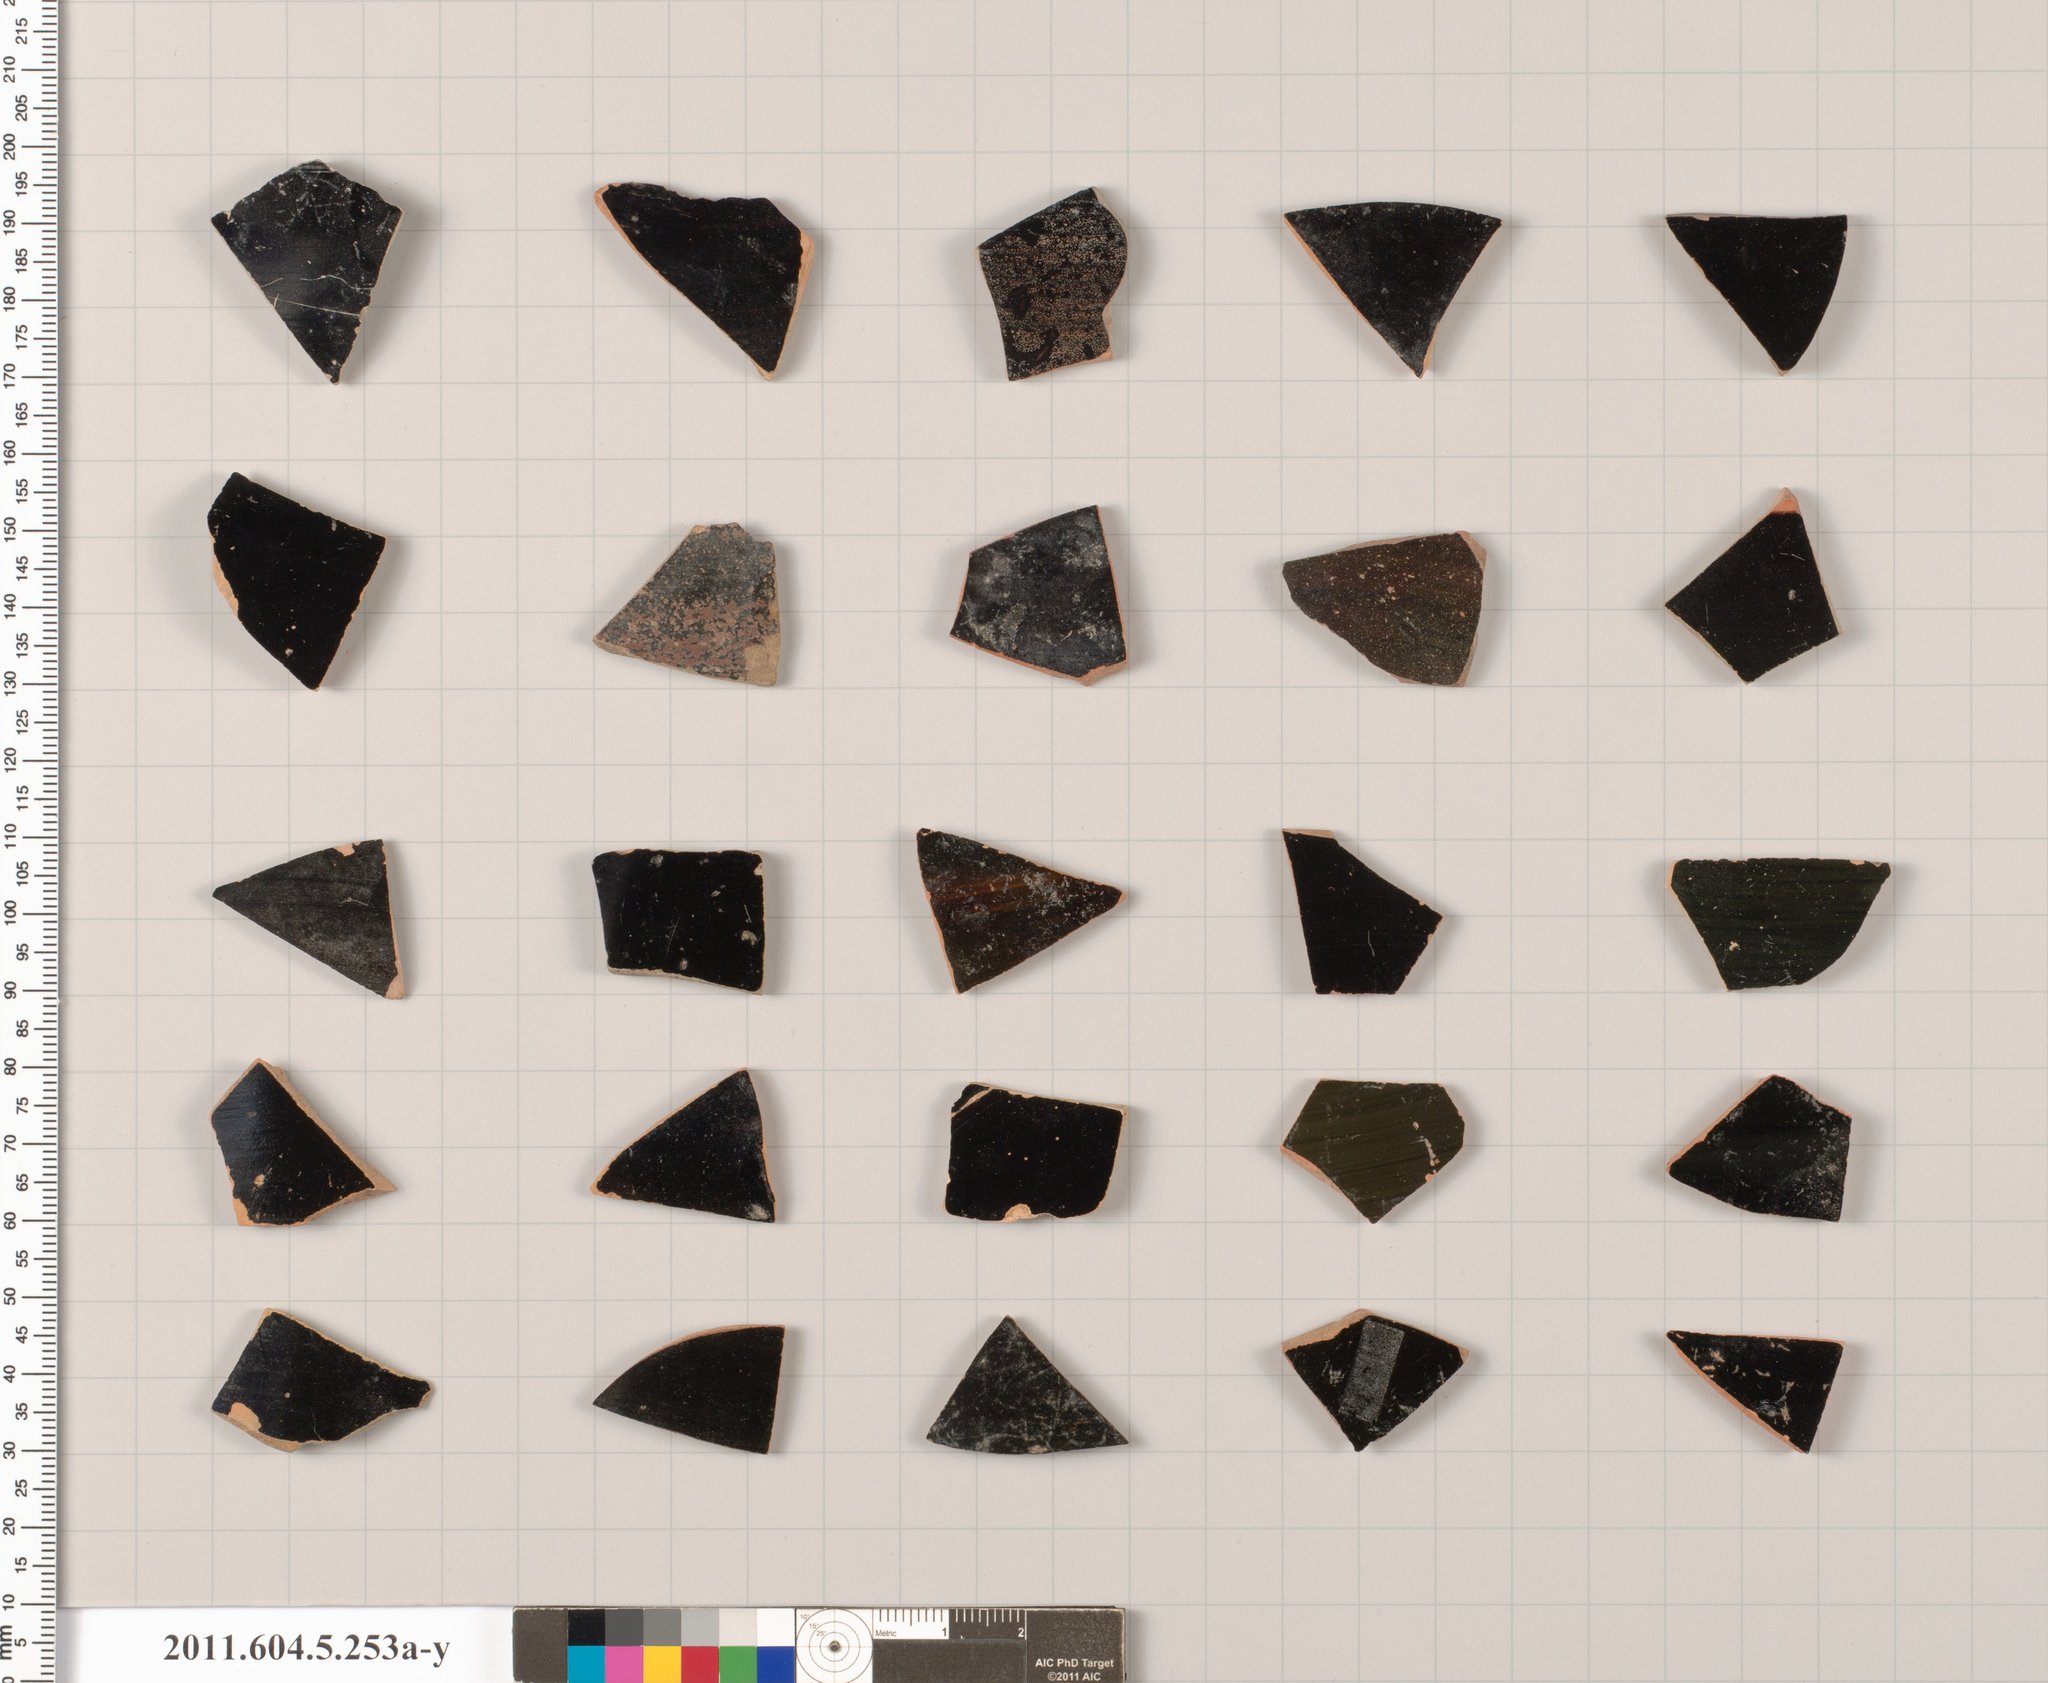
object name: kylix fragment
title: Terracotta fragments of kylikes (drinking cups)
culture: greek, attic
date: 600-401 BCE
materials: terracotta